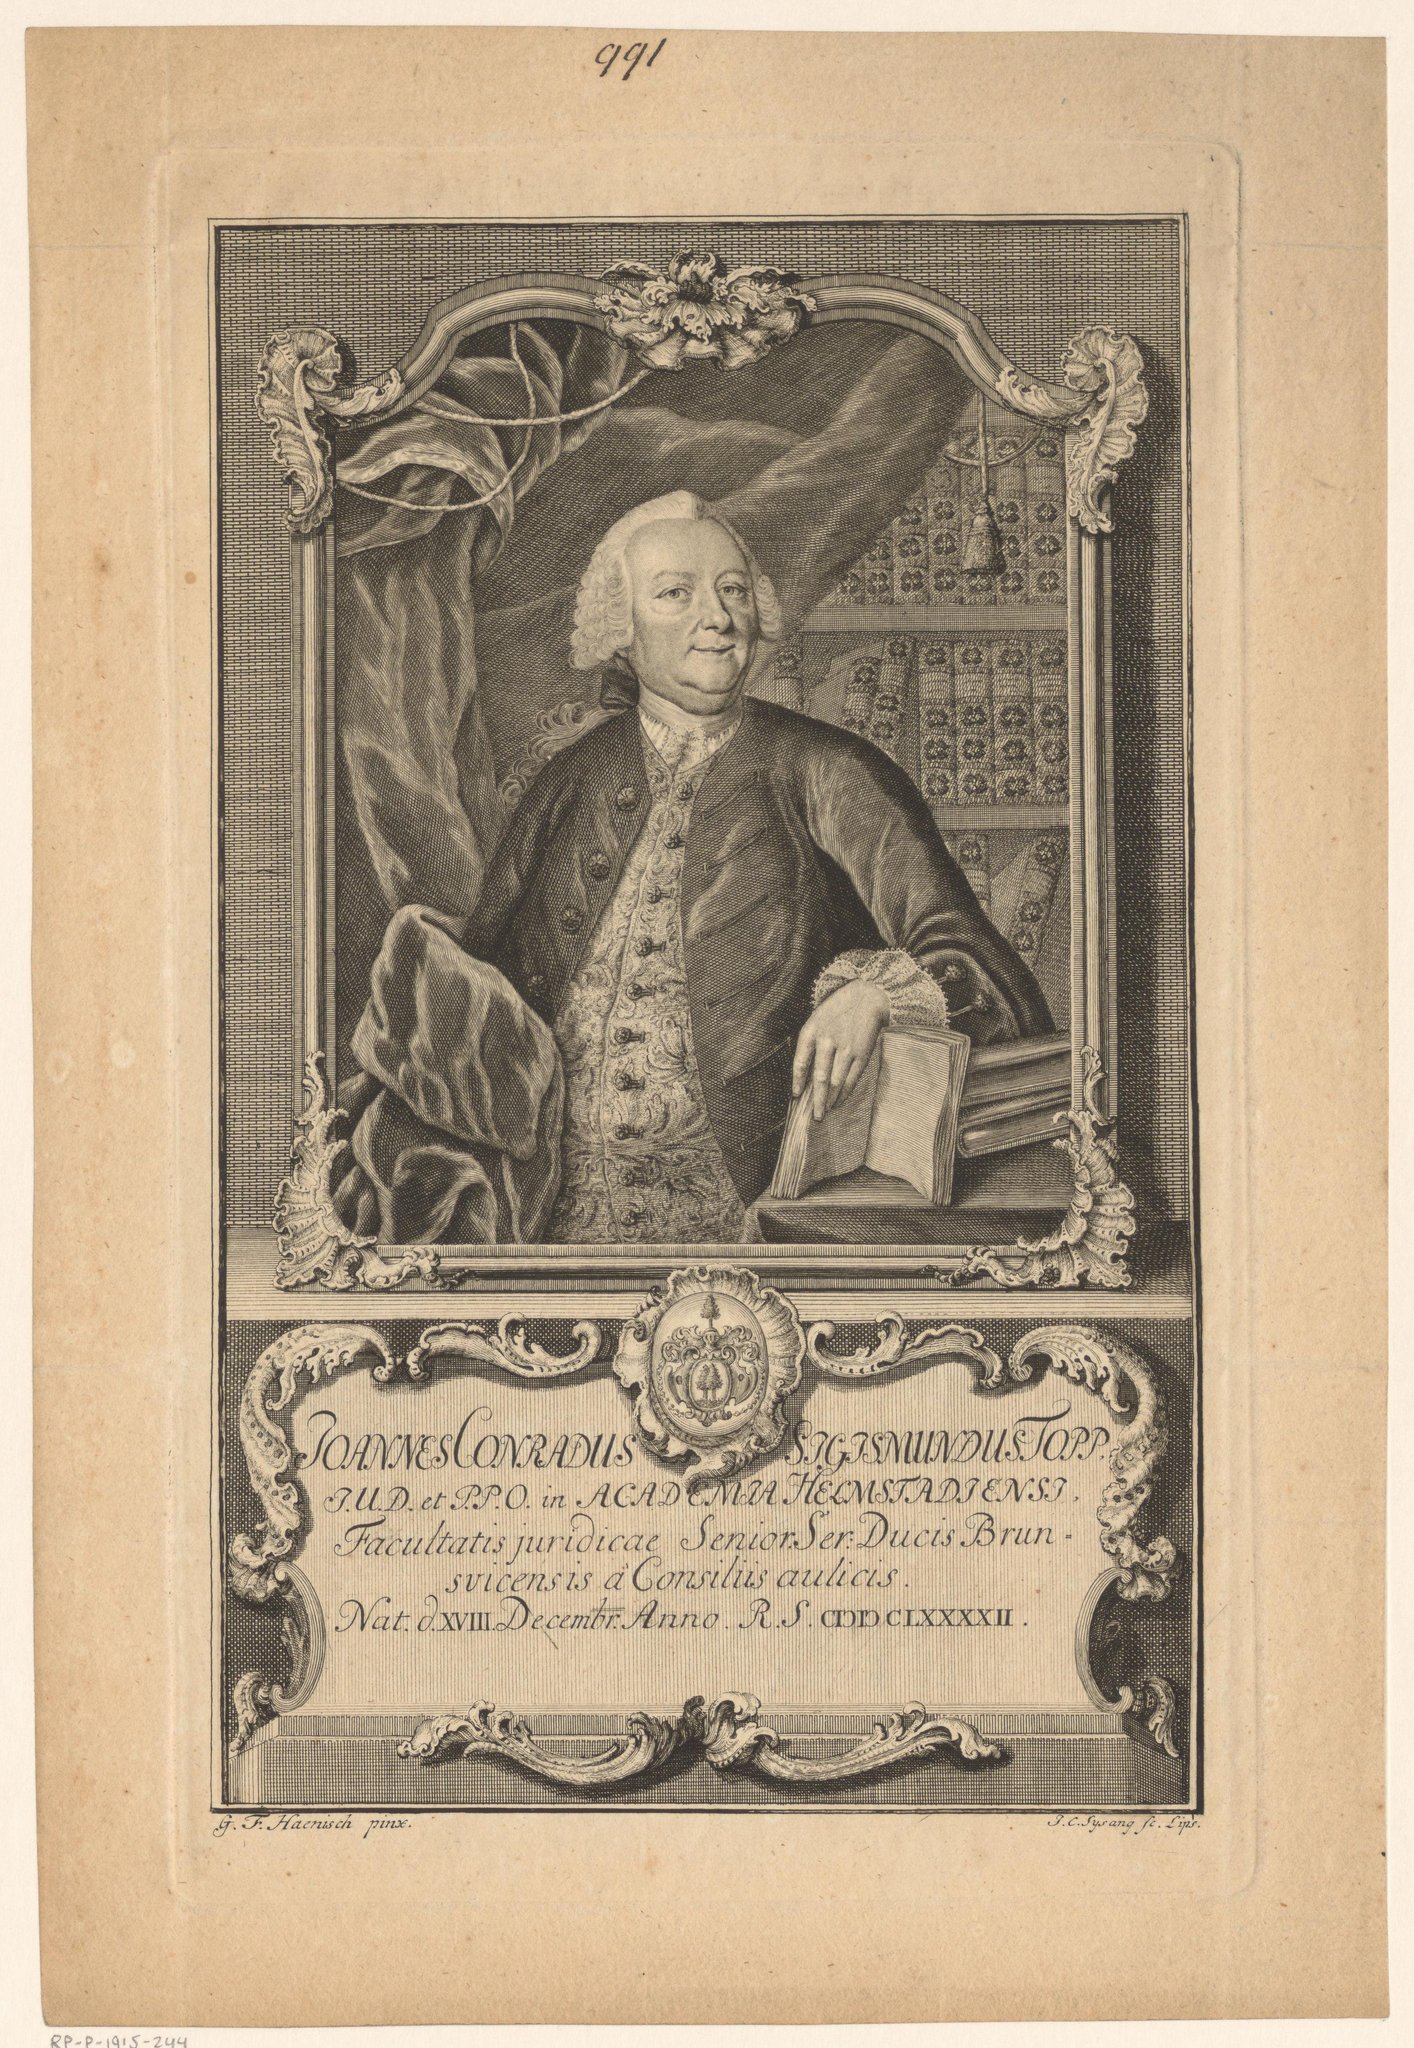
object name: print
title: Portret van Johann Conrad Sigmund Topp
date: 1748-1757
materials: paper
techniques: engraving, etching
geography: leipzig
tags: bookshelves, historical persons, book, armorial bearing, heraldry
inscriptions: number: ‘991’, collector's mark: Lugt 2228